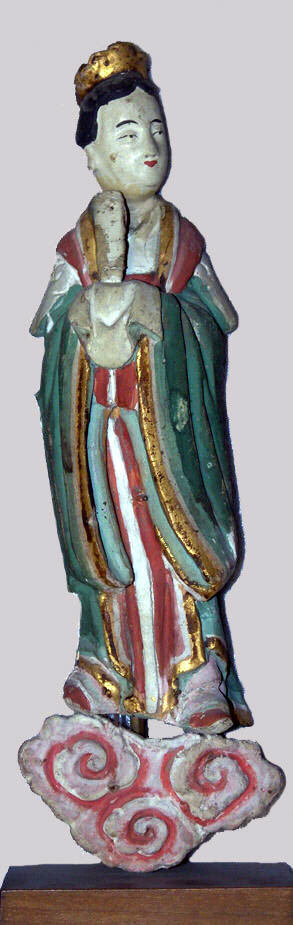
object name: statuette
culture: chinese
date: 1601-1700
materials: mud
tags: men